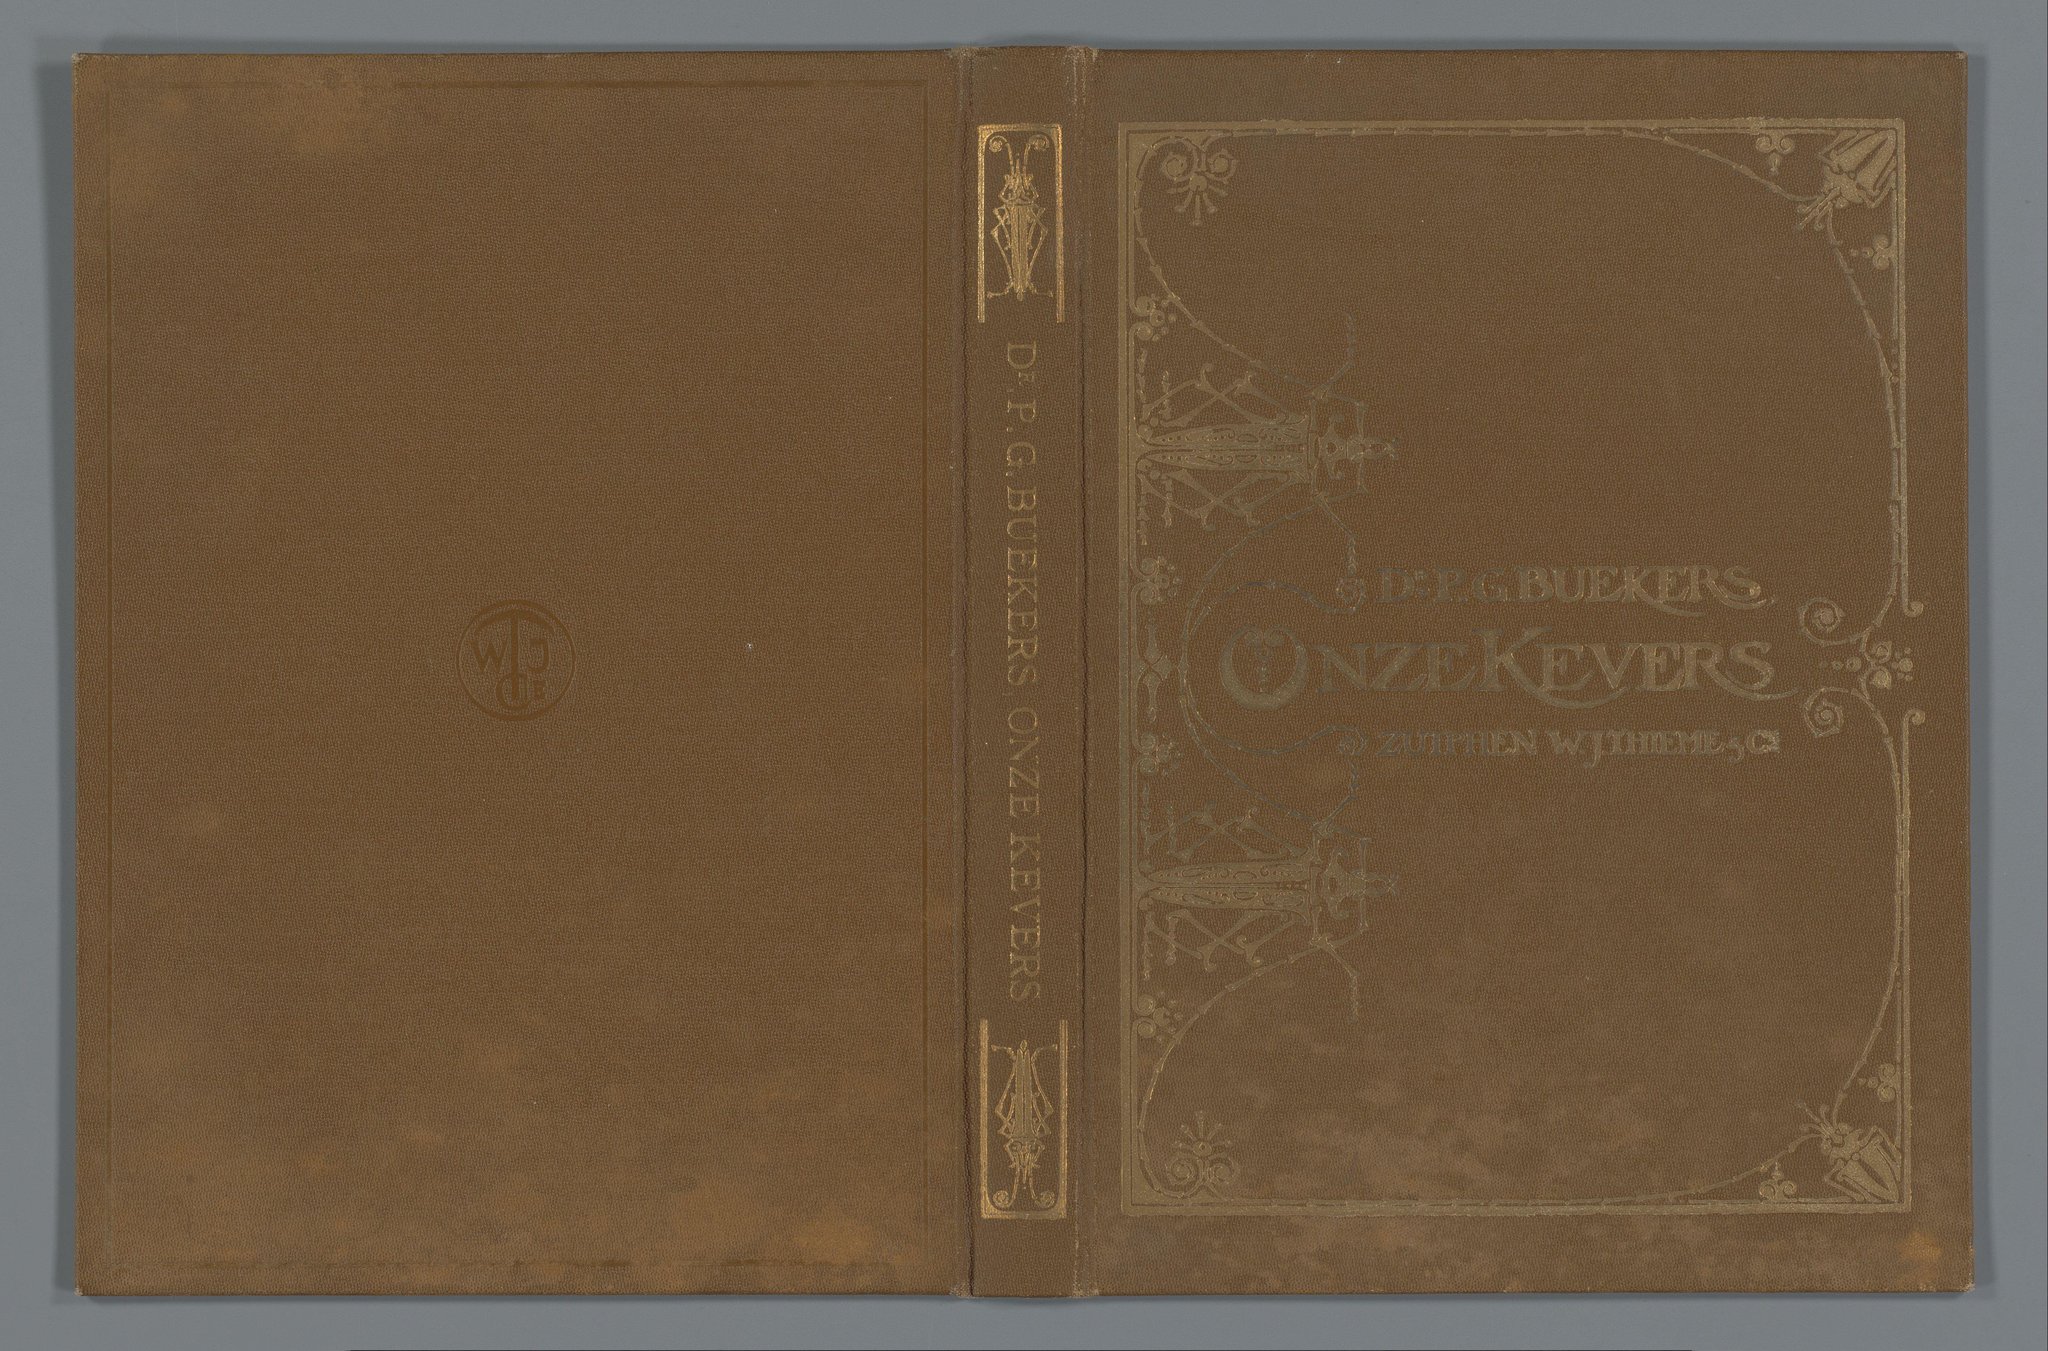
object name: binding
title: Boekband voor: P.G. Buekers, Onze kevers, 1912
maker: Anonymous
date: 1912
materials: cardboard, linen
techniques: gold embossing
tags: ornaments ~ art, insects: beetle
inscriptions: collector's mark: ‘R:MVS.’, check stamp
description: Boekband voor: Buekers, Peter Gijsbert. Onze kevers. Zutphen: Thieme & Cie, 1912.